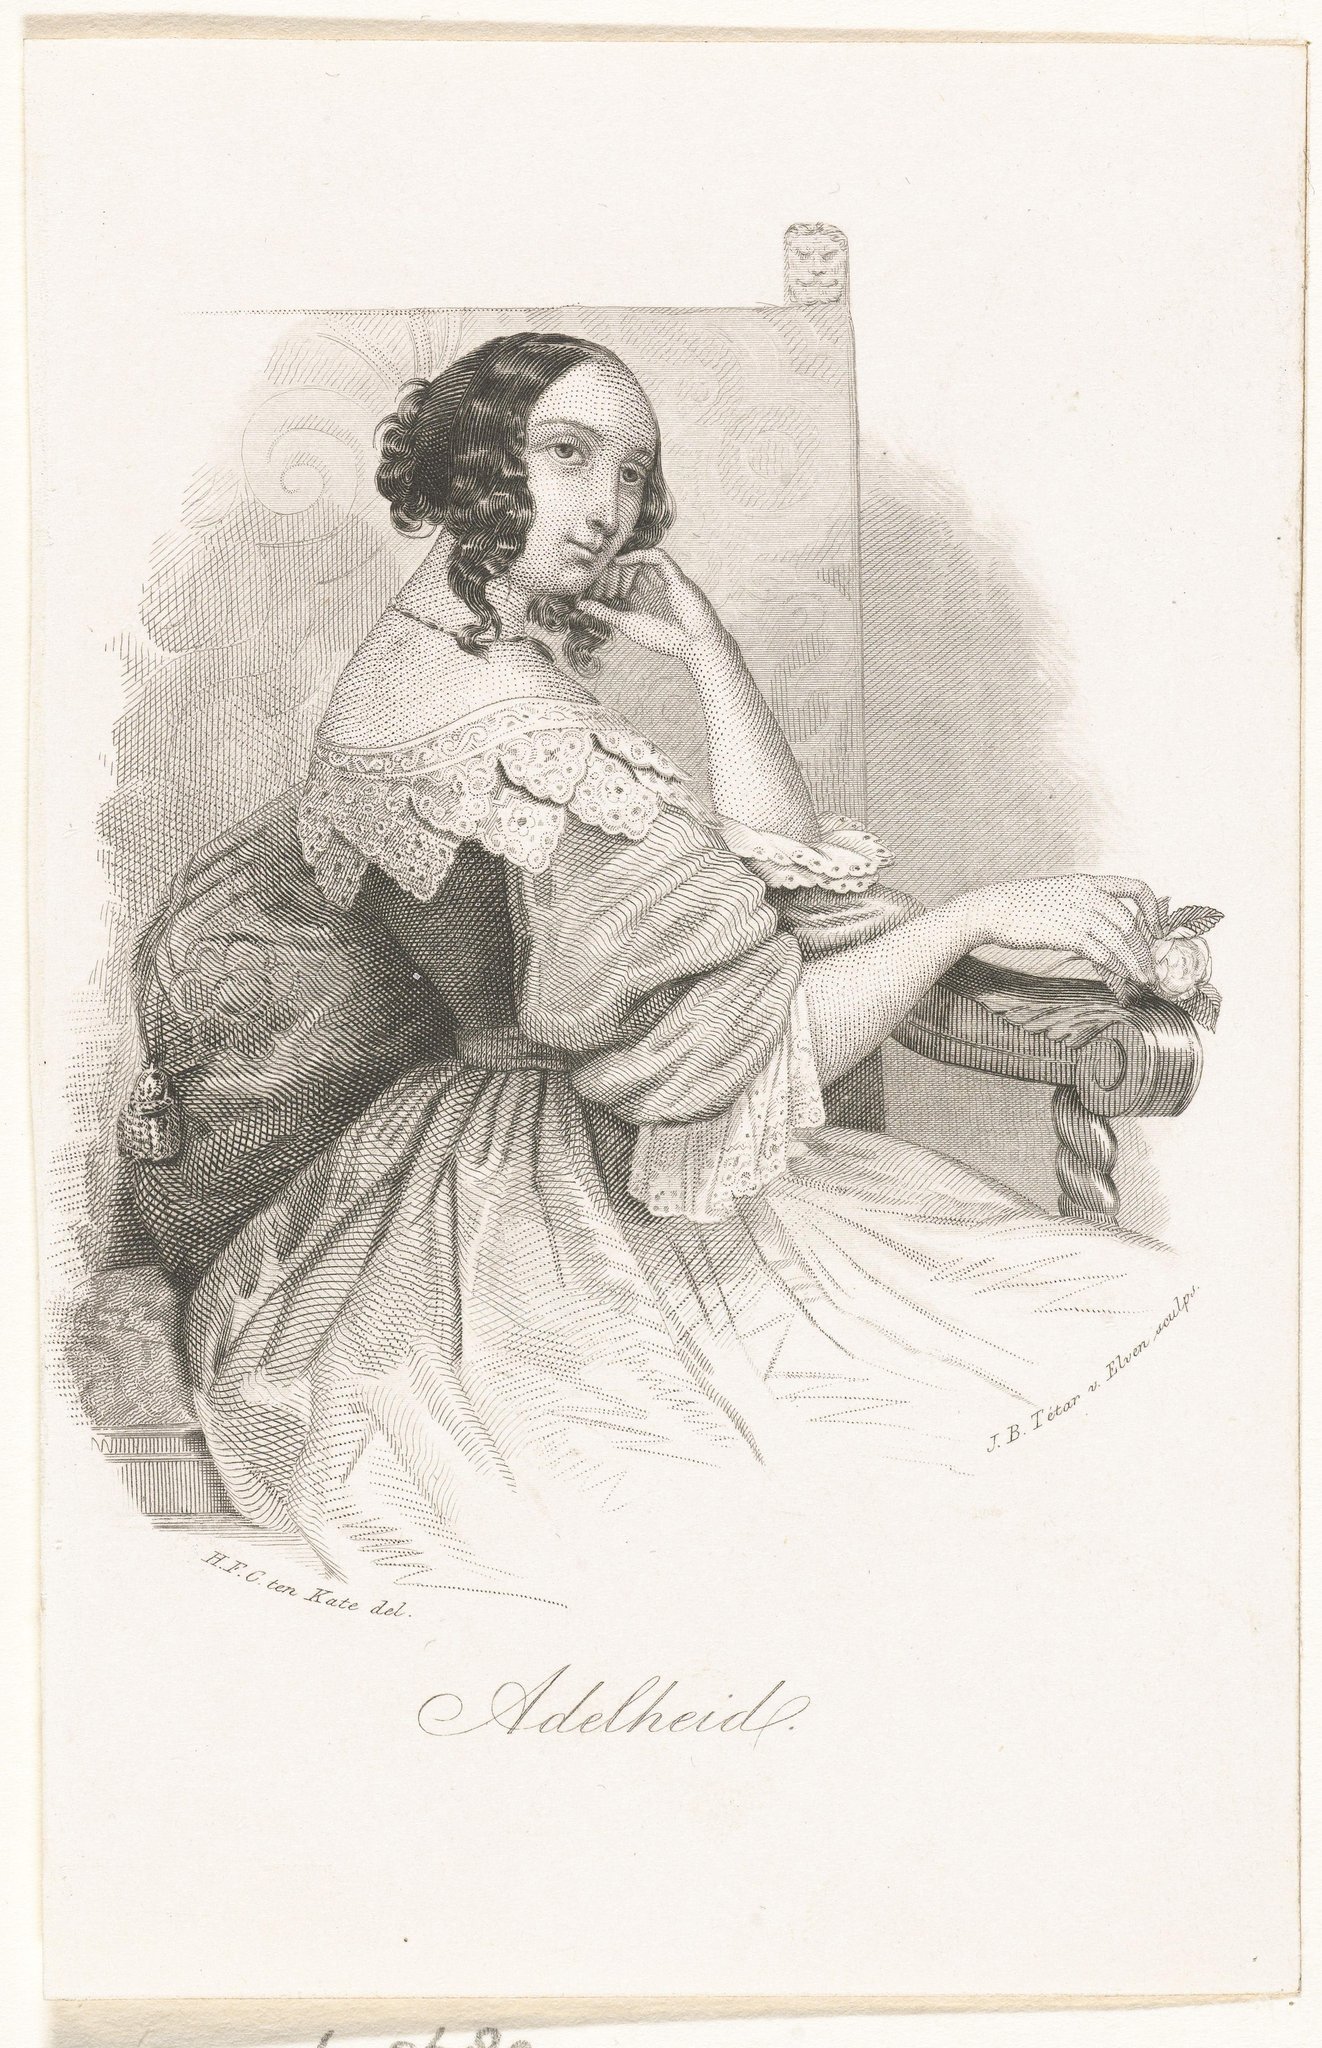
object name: print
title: Adelheid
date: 1849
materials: paper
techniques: engraving, etching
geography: the hague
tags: adolescent, young woman, maiden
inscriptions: collector's mark: Lugt 2228, inscription: ‘Alm. v h. Schoone en Goede v 1849’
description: Portret van een jongedame, dwars op een stoel gezeten, met haar ene hand bij het gezicht en in de andere een roos. De prent is gemaakt voor de Nederlandstalige Almanak Voor het Schoone en Goede.